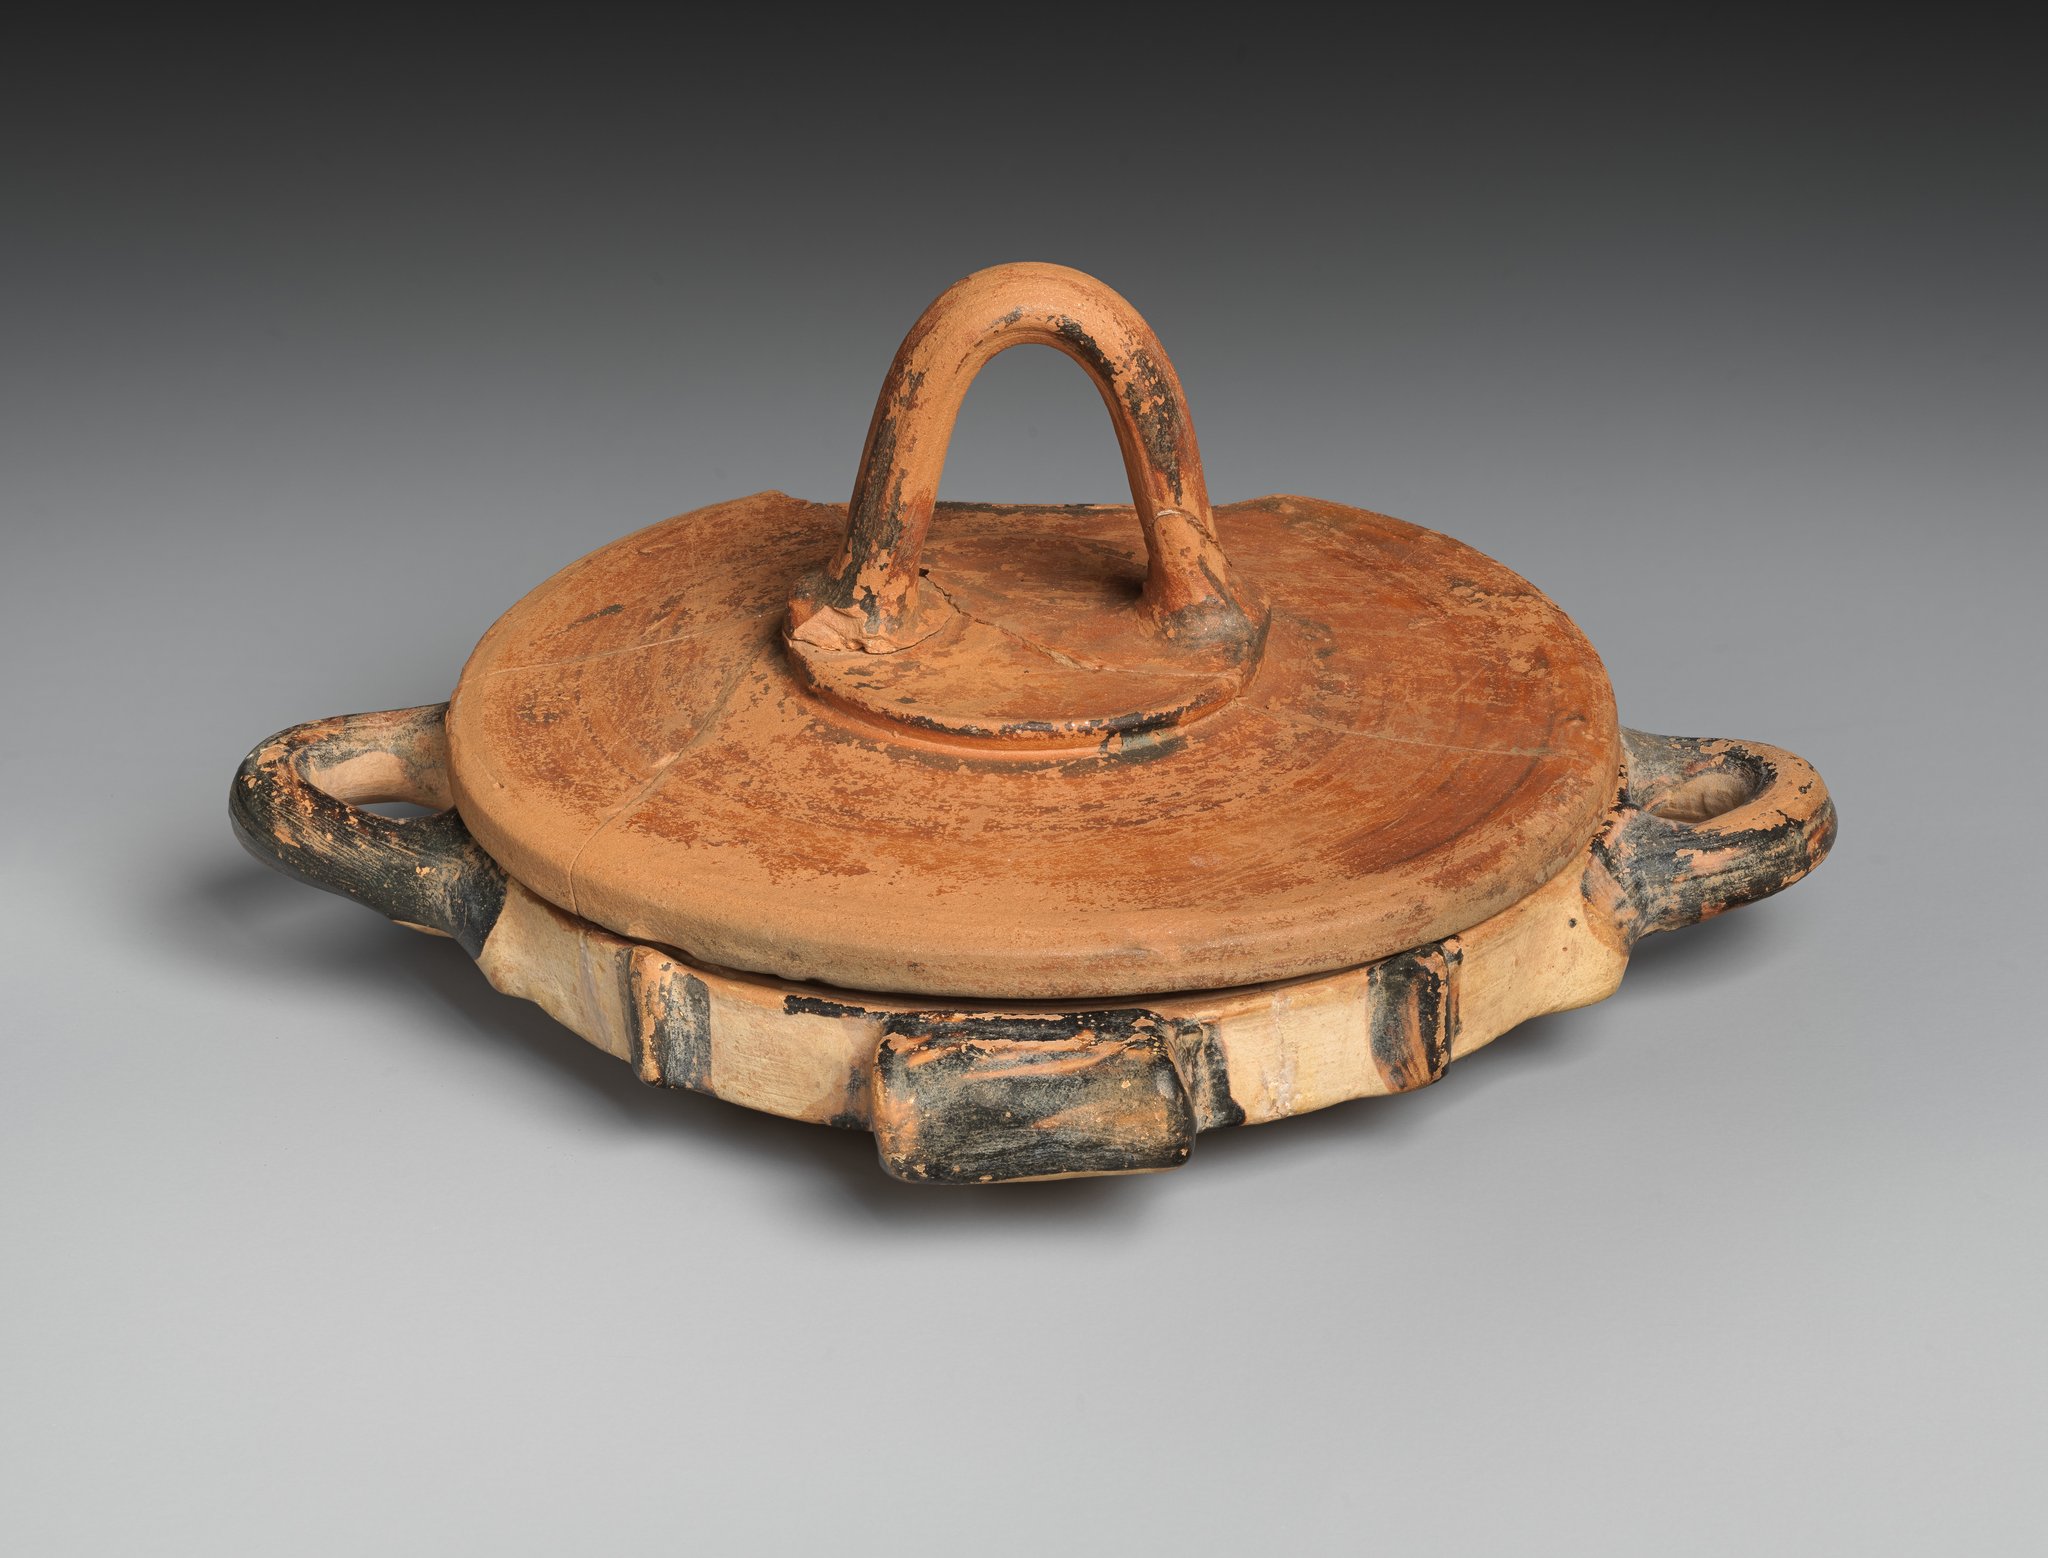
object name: dish, flat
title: Shallow terracotta dish with lid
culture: lydian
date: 600-501 BCE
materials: terracotta